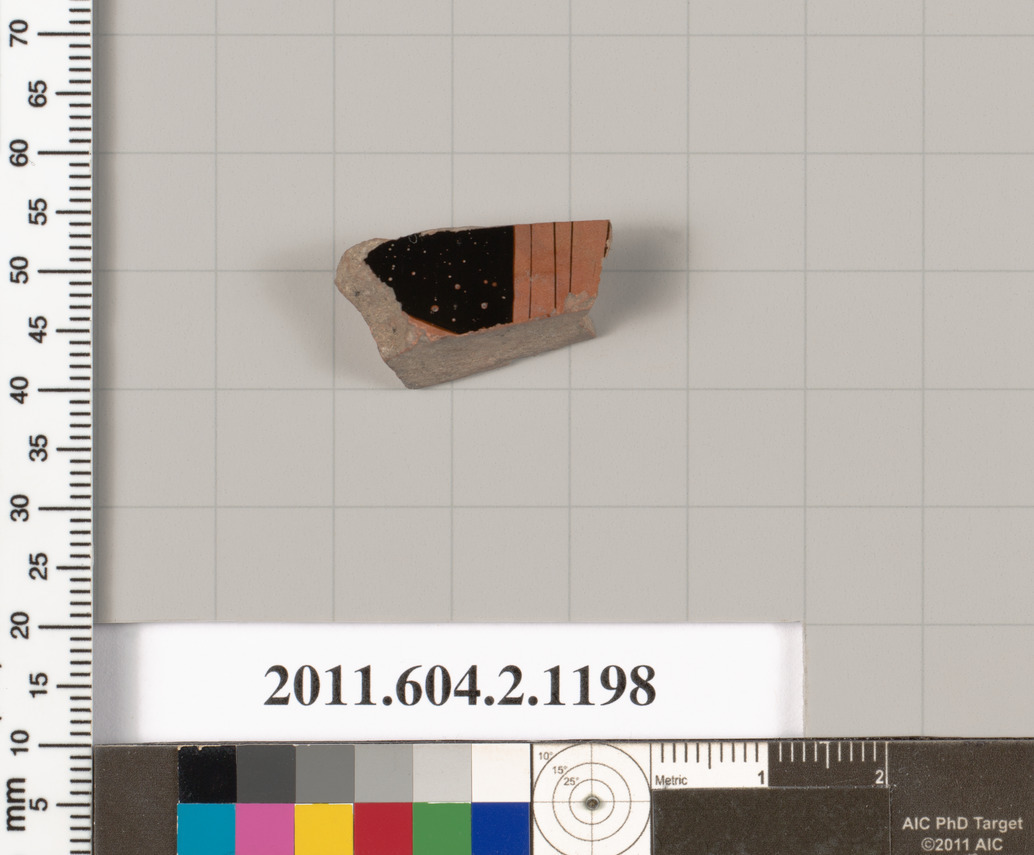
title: Terracotta fragment from an open shape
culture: greek, attic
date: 450-401 BCE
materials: terracotta